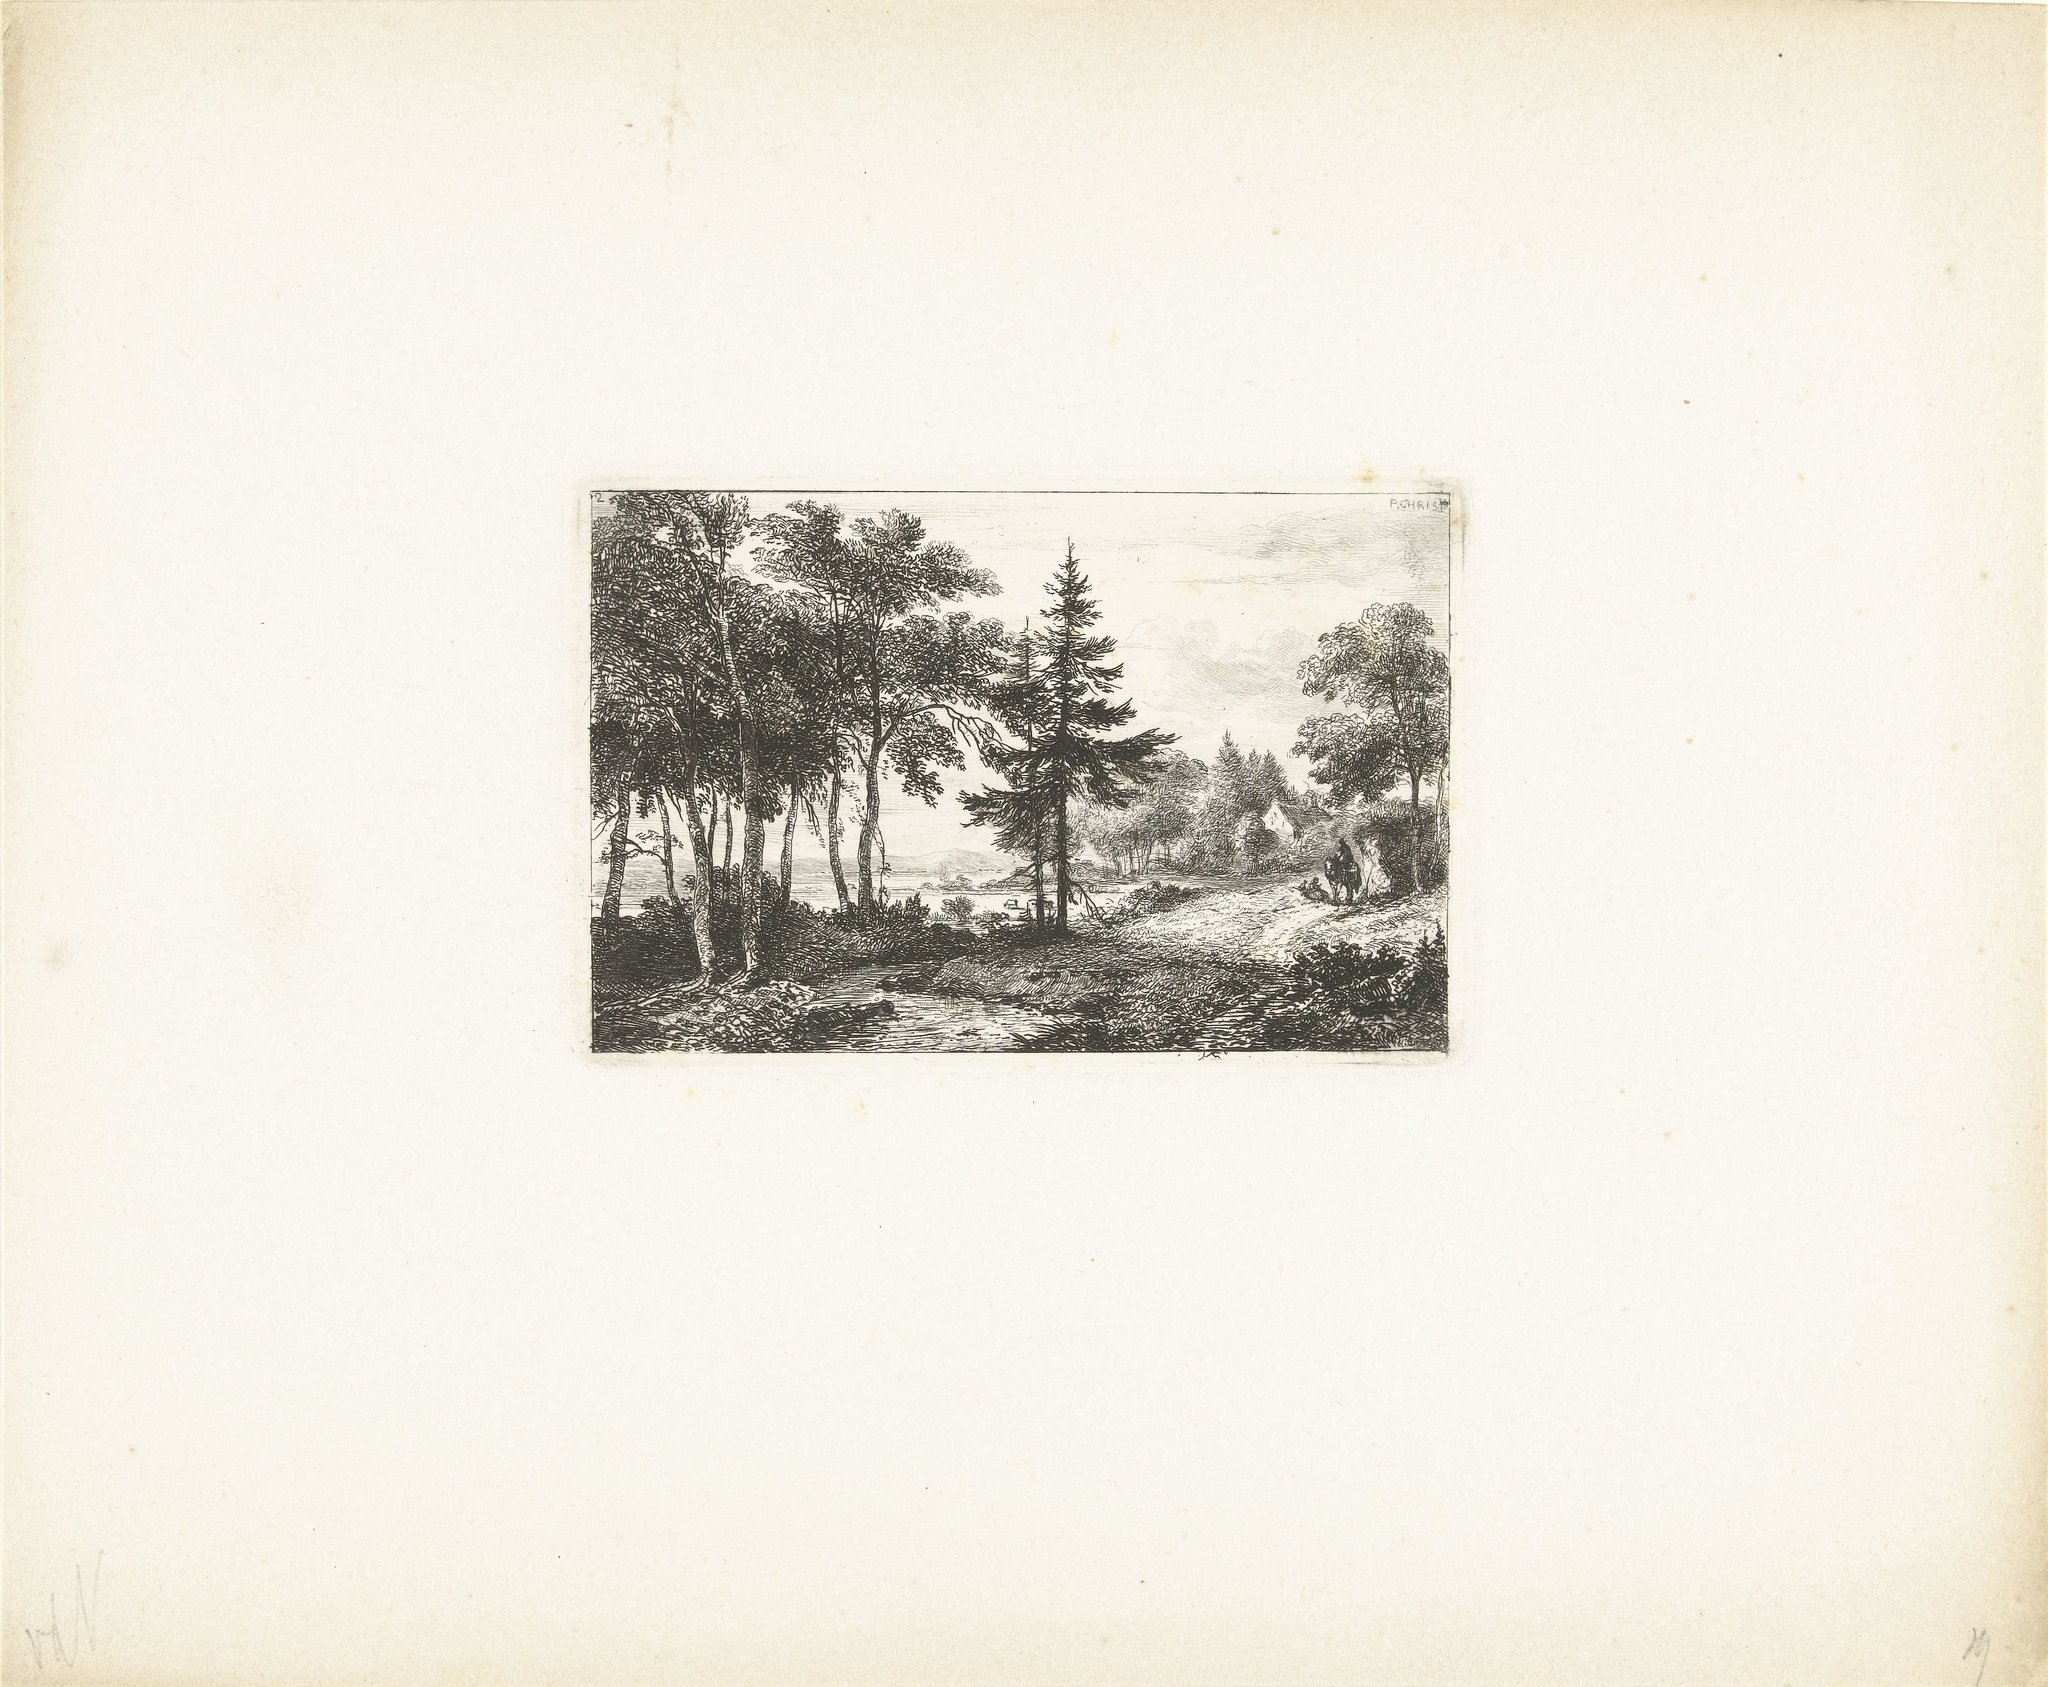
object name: print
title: Landschap met denneboom en ruiter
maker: pieter casper christ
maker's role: draughtsman, print maker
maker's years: 1822-1888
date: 1860-1870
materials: paper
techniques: etching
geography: arnhem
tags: landscapes with waters, waterscapes, seascapes (in the temperate zone) (+ landscape with figures, staffage)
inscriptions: collector's mark: Lugt 2228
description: Uit inventarisboek: Op den omslag: Zestal etsen door P. Christ. Arnhem H.B. Breyer. Prijs 2,50.